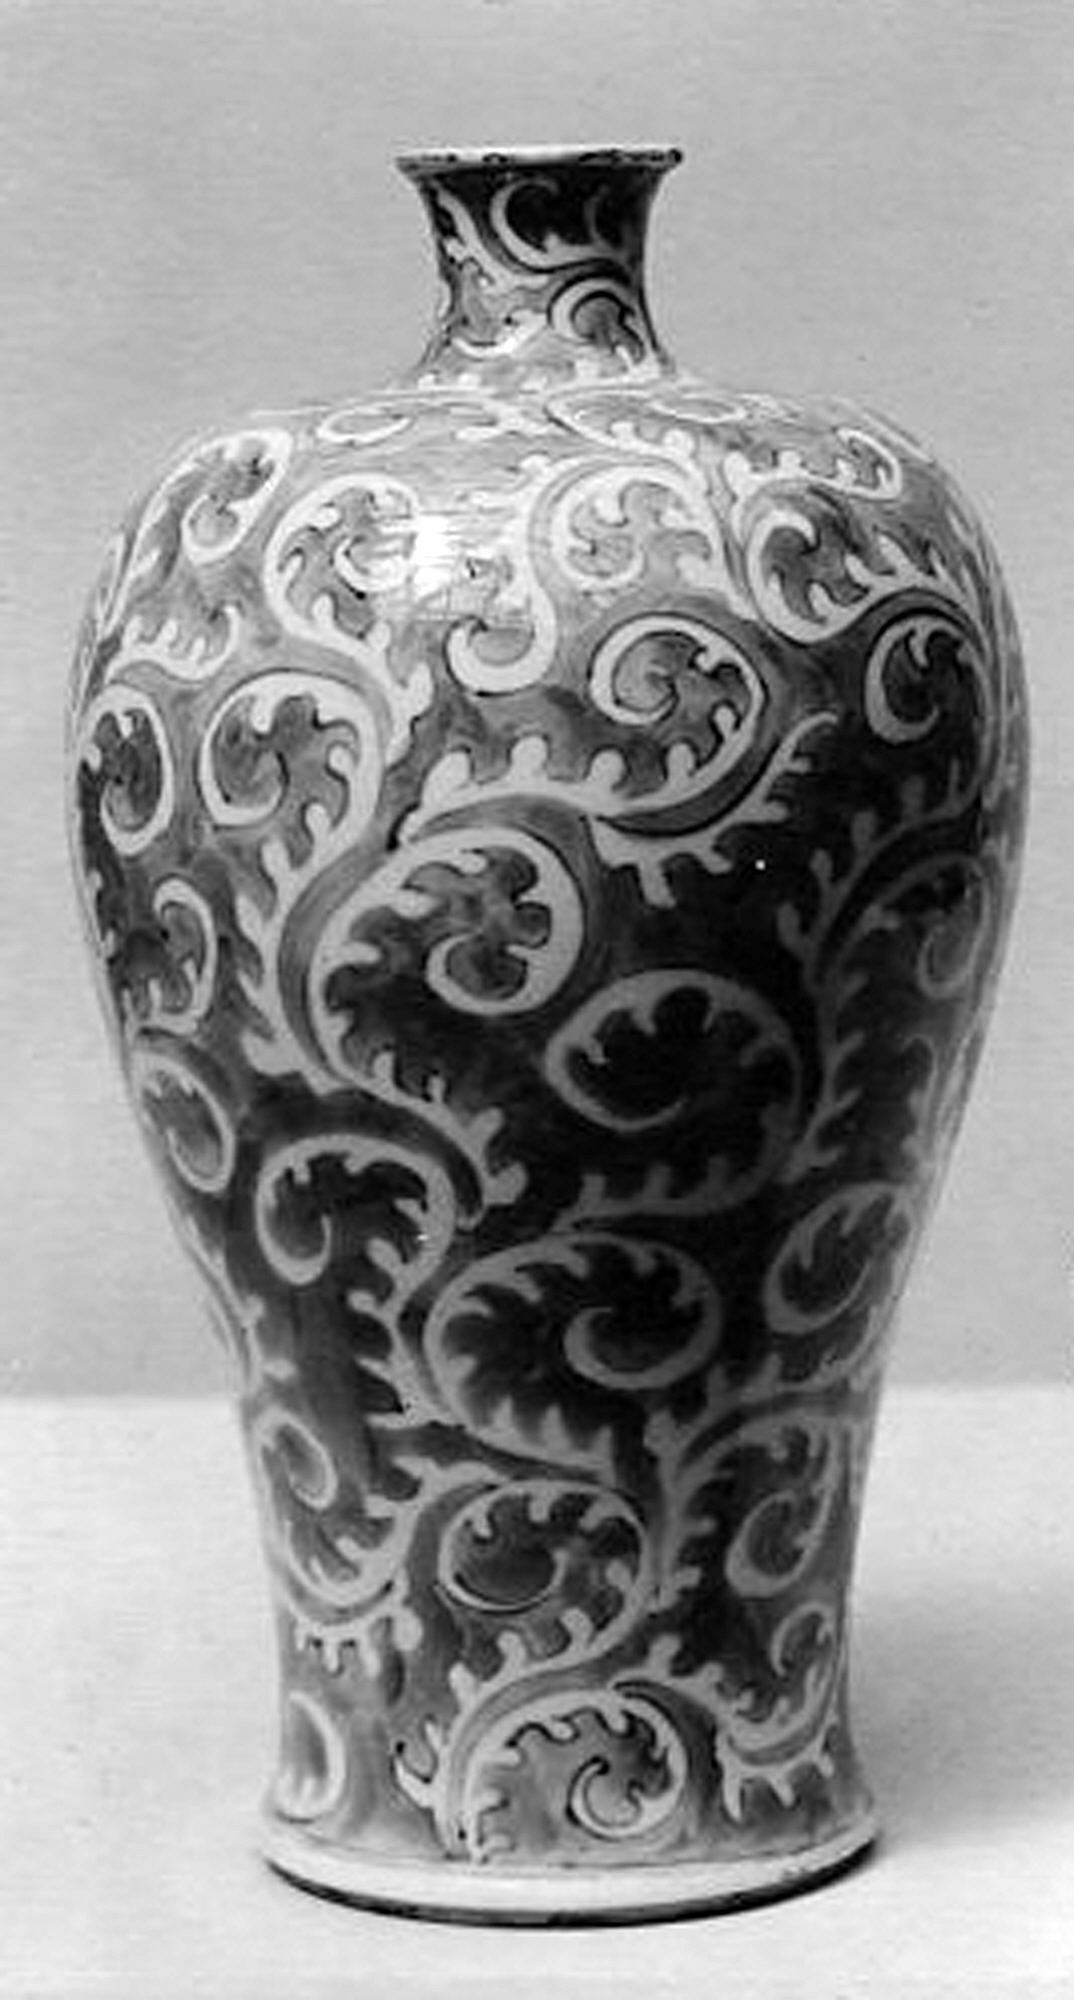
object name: vase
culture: chinese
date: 1662-1722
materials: porcelain